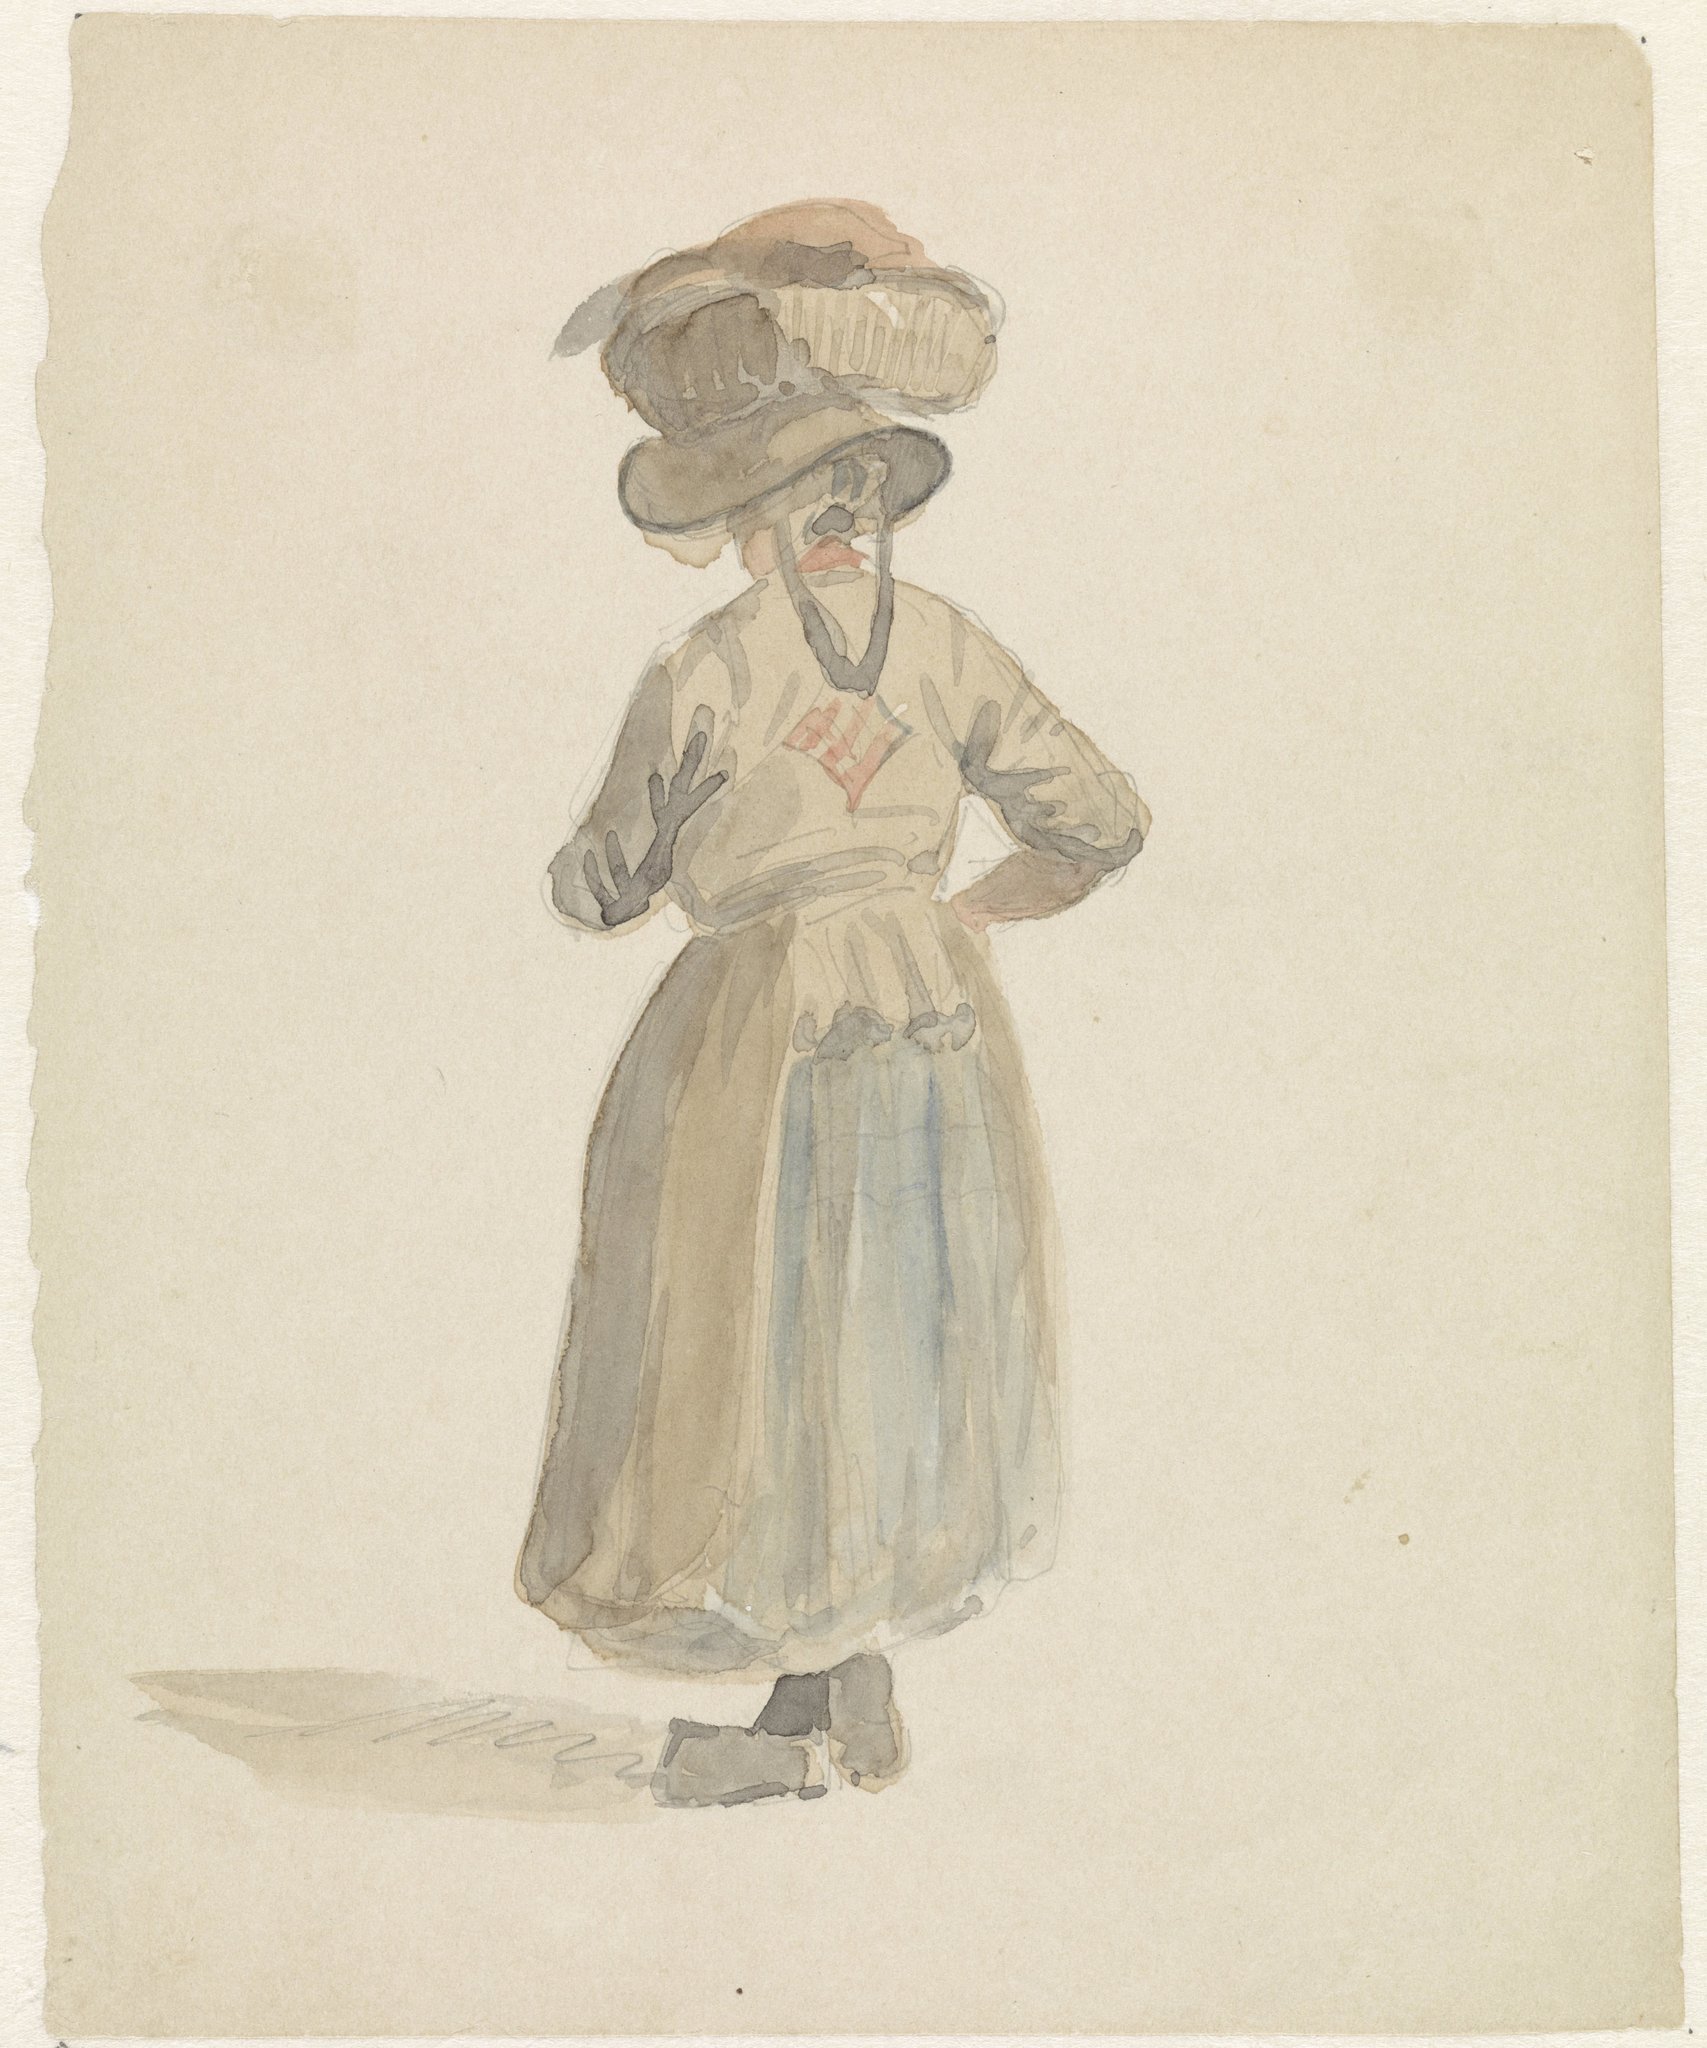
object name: watercolor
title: Figuurstudie van een vrouw met een mand op het hoofd, van achteren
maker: adrianus eversen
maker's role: draughtsman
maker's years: 1818-1897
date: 1828-1897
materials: paper, pencil, watercolor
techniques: brush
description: Figuurstudie van een op de rug geziene staande vrouw met een mand met waar op het hoofd.